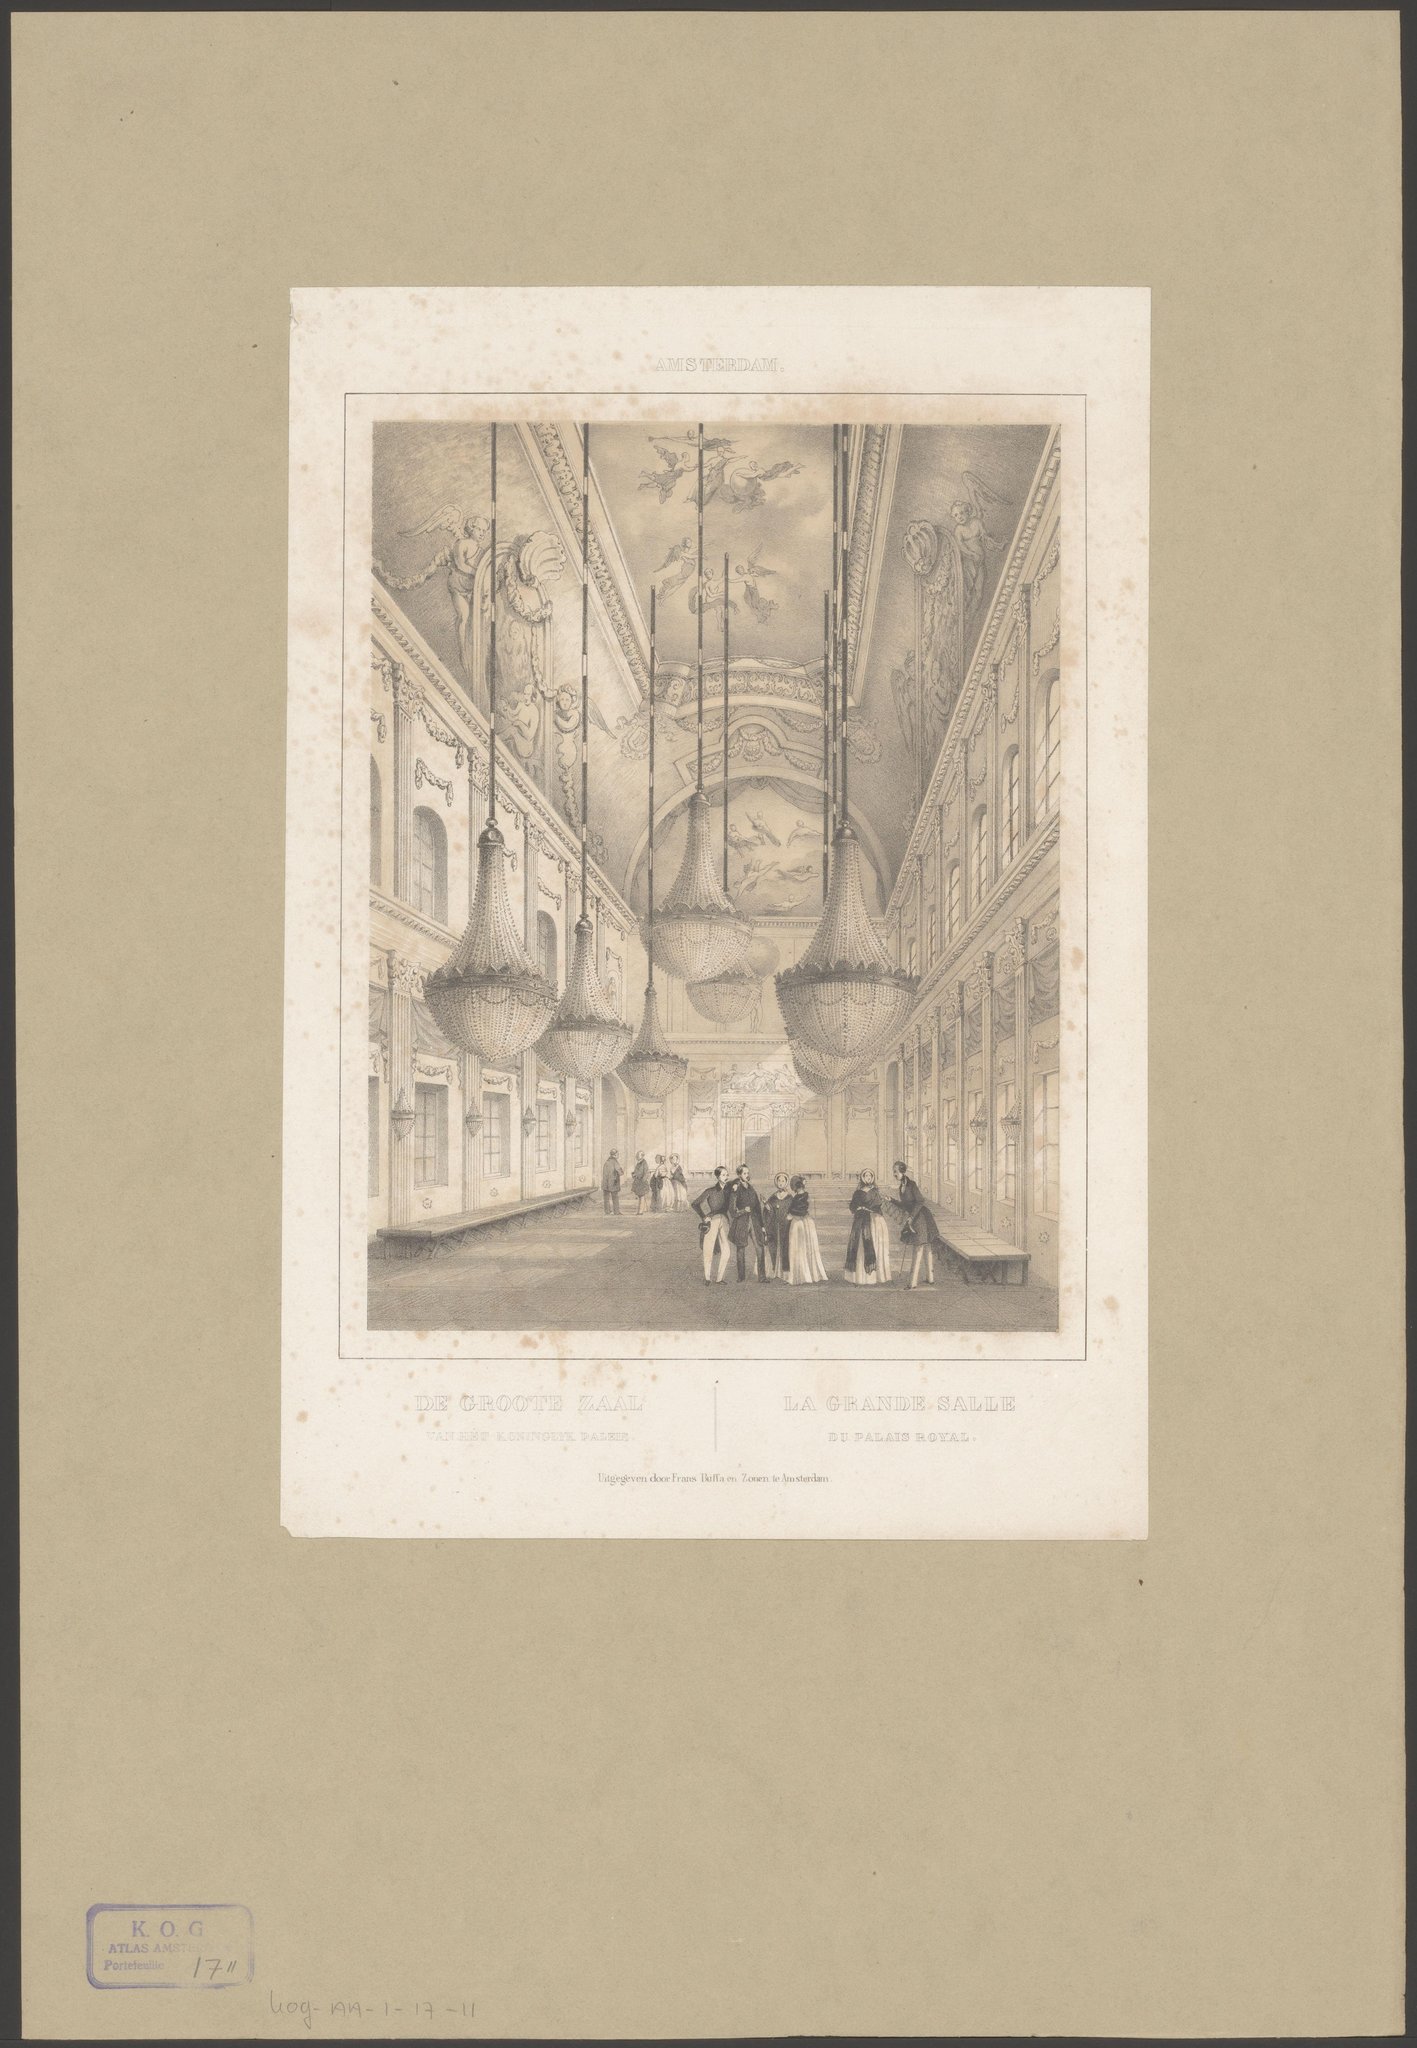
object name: print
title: De Groote Zaal van het Koninglyk Paleis / La Grande Salle du Palais Royal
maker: Anonymous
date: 1836-1951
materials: paper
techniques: tone lithography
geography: amsterdam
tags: townhall, royal palace of amsterdam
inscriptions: collector's mark: ‘17 11’ Lugt 1641b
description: Onderwerpsrubriek binnen de Atlas Amsterdam: Nieuwe Stadhuis, van binnen: Groote zaal, Raadkamer, Schepenkamer, Troonzaal, Mozeszaal, Zitkamer.